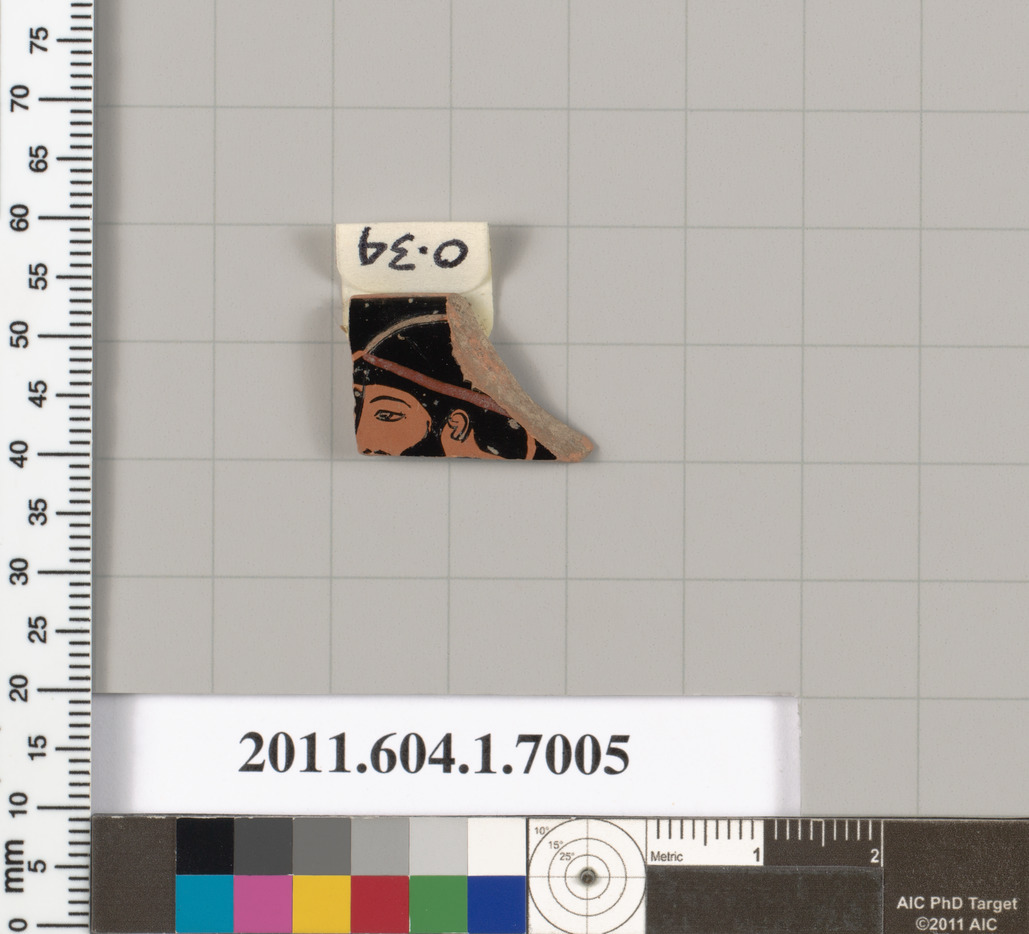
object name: kylix fragment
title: Terracotta rim fragment of a kylix (drinking cup)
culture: greek, attic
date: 500-480 BCE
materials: terracotta